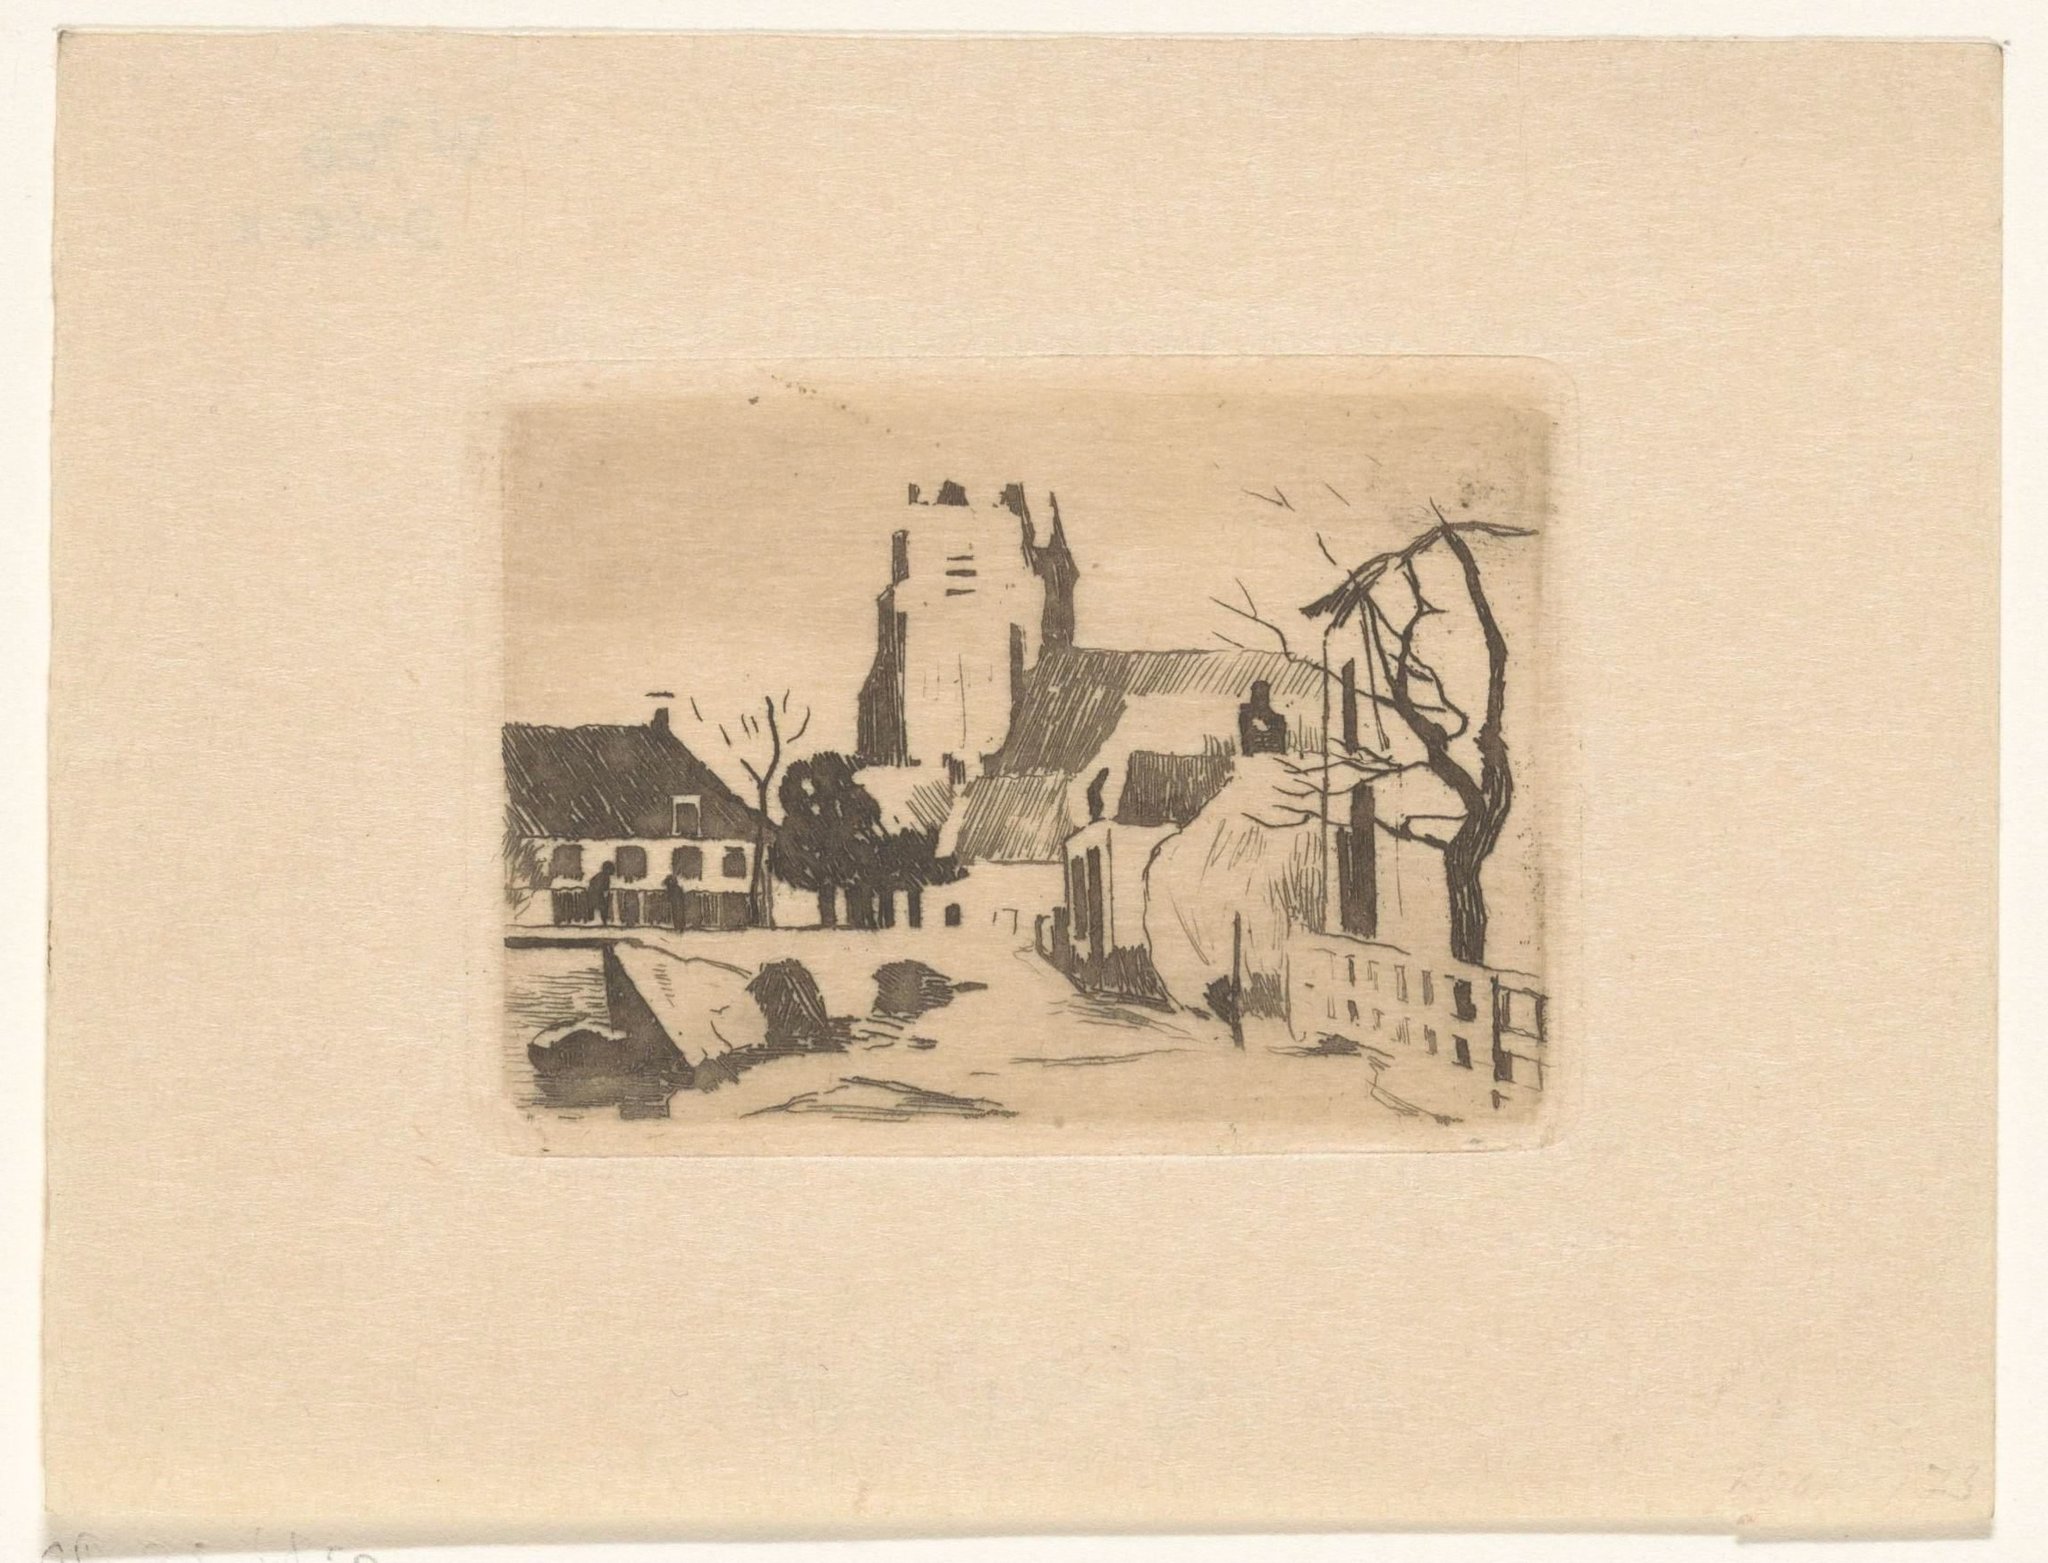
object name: print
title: Gezicht op de Grote Kerk in Wijk bij Duurstede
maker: willem witsen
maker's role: draughtsman, painter, print maker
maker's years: 1860-1923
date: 1913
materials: paper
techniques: etching, intaglio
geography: amsterdam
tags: village street, housing, building of church, wijk bij duurstede